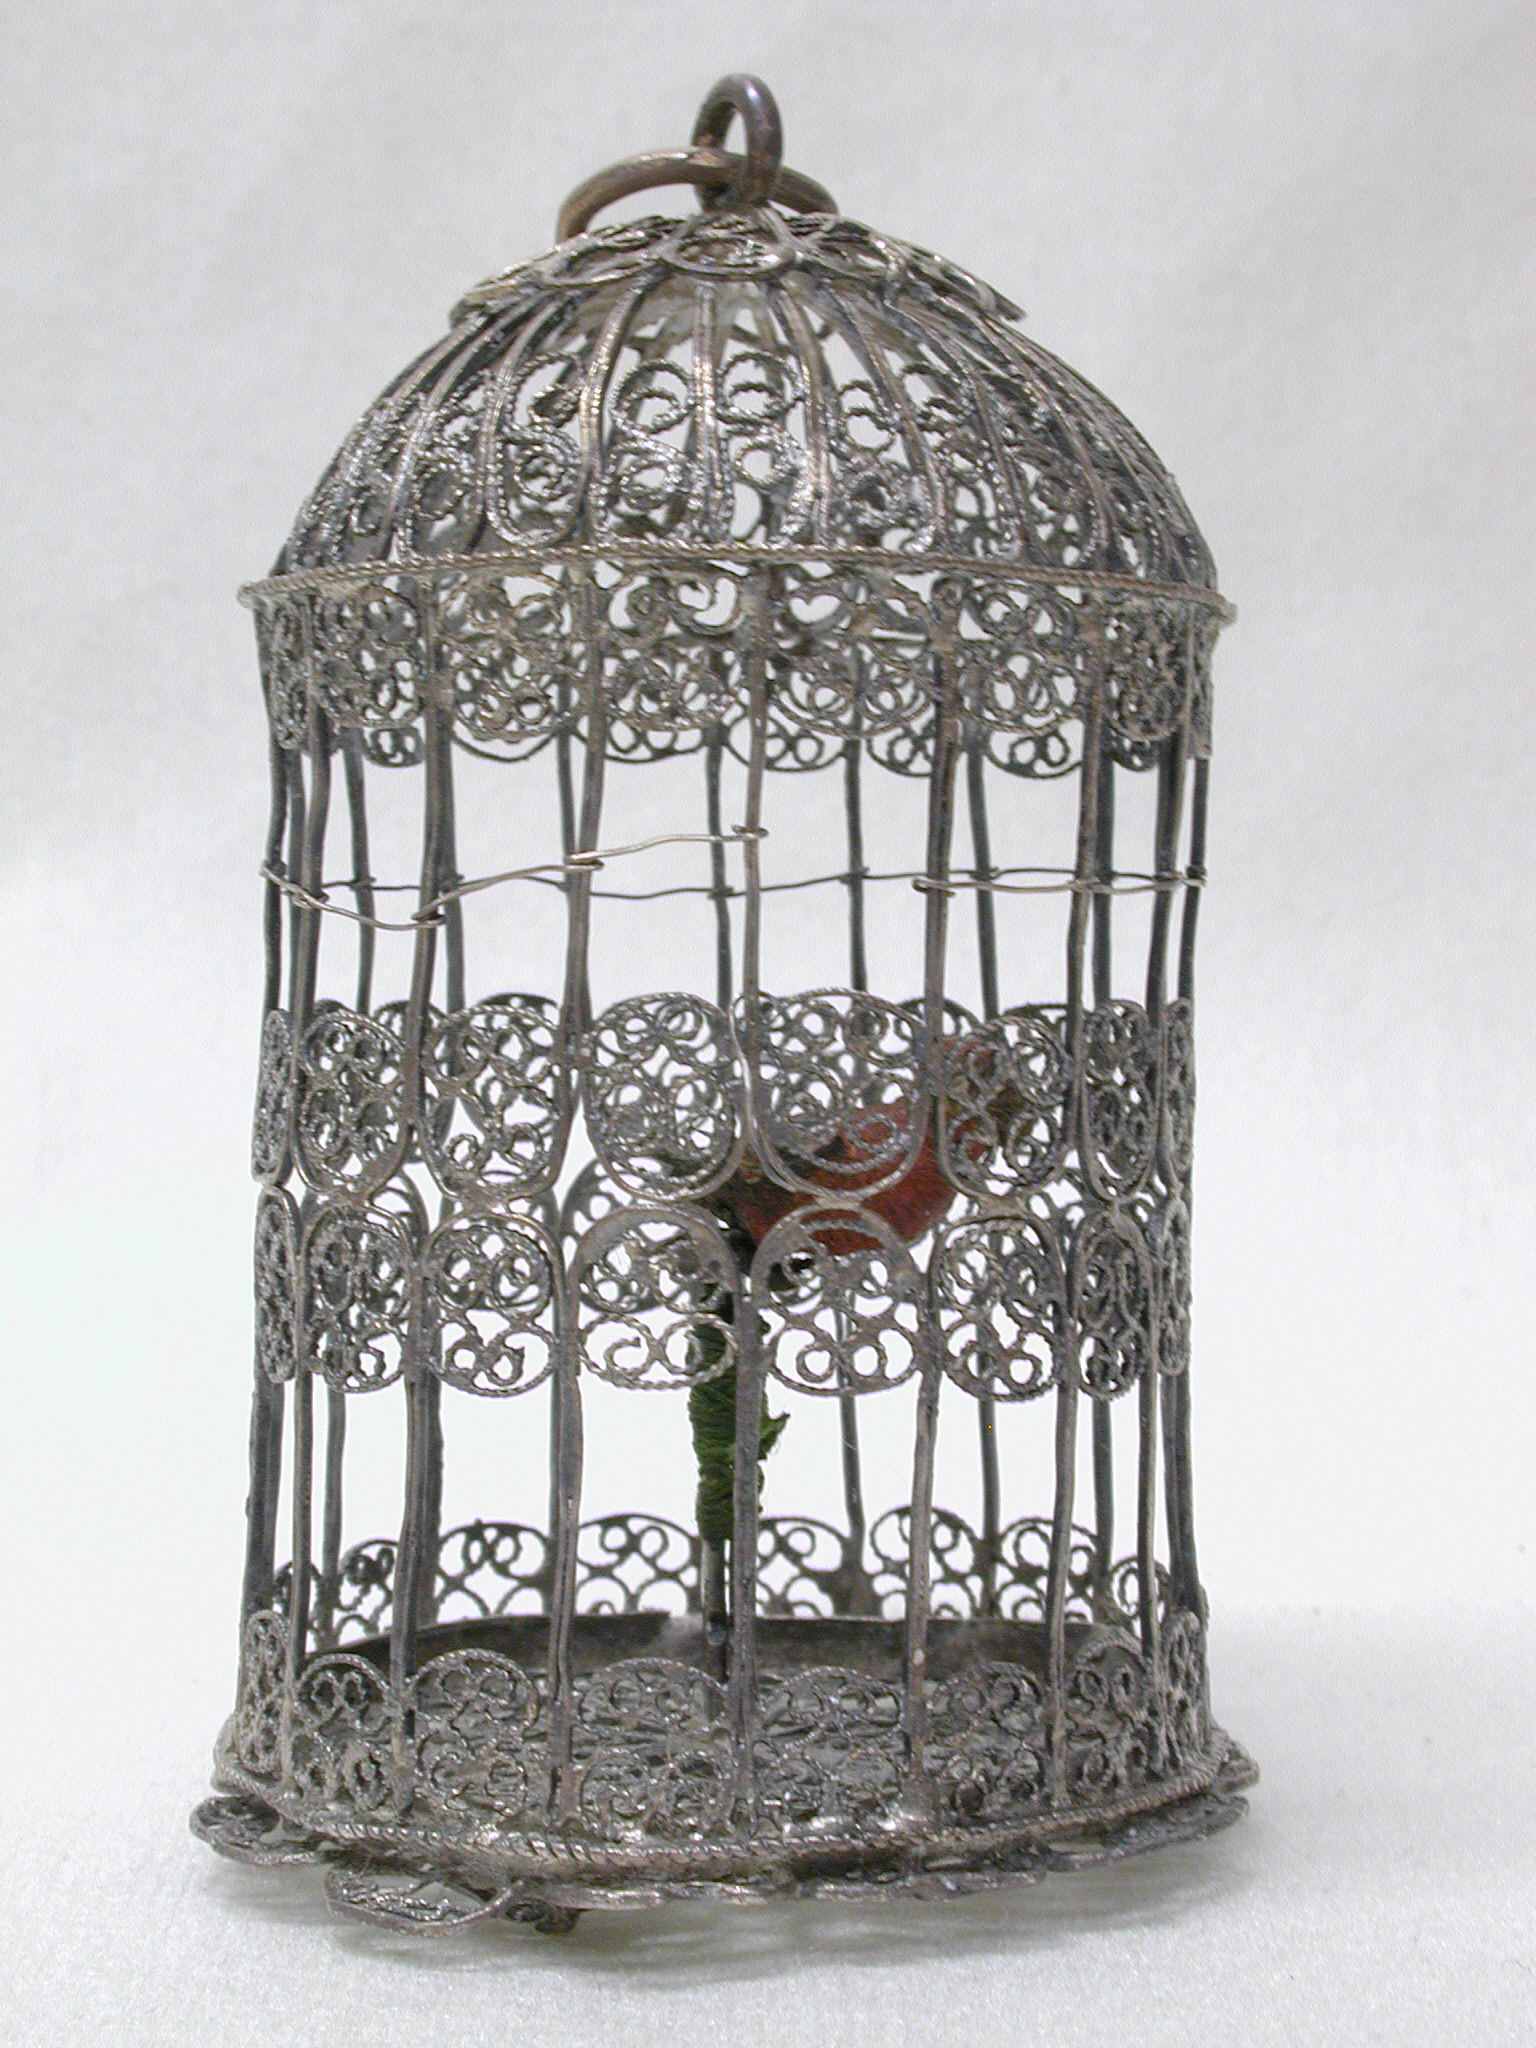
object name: birdcage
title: Miniature birdcage (part of a set)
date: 1675-1700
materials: silver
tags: birds